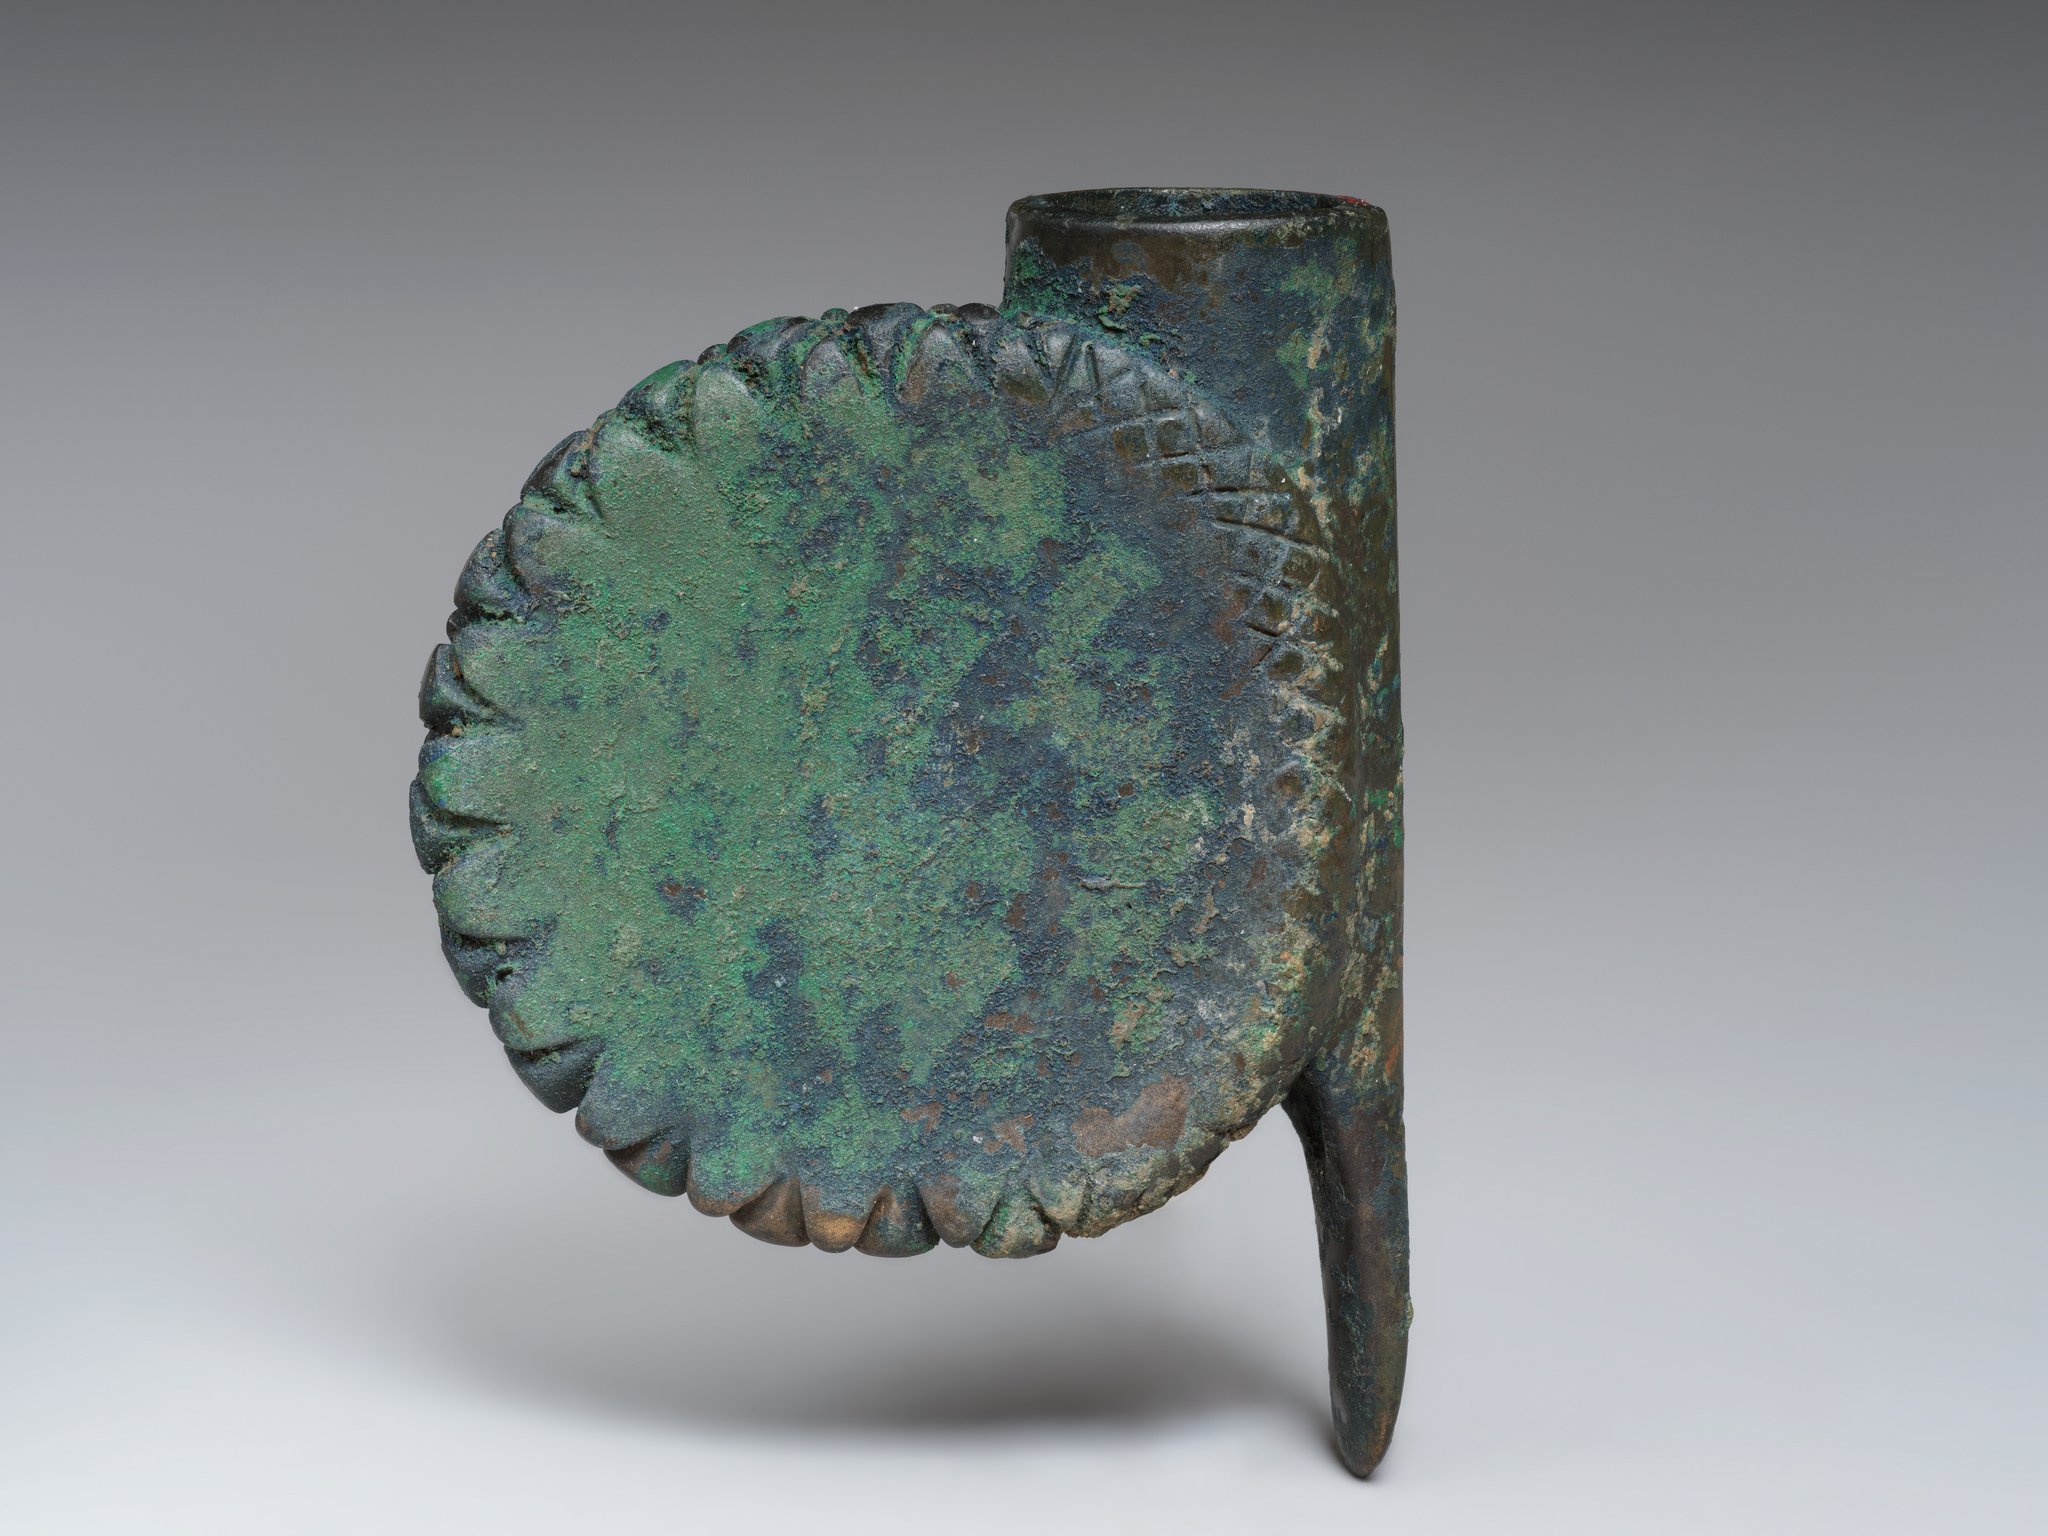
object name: axe or mace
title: Axe or mace head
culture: hattian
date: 2300-2000 BCE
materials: bronze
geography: central anatolia